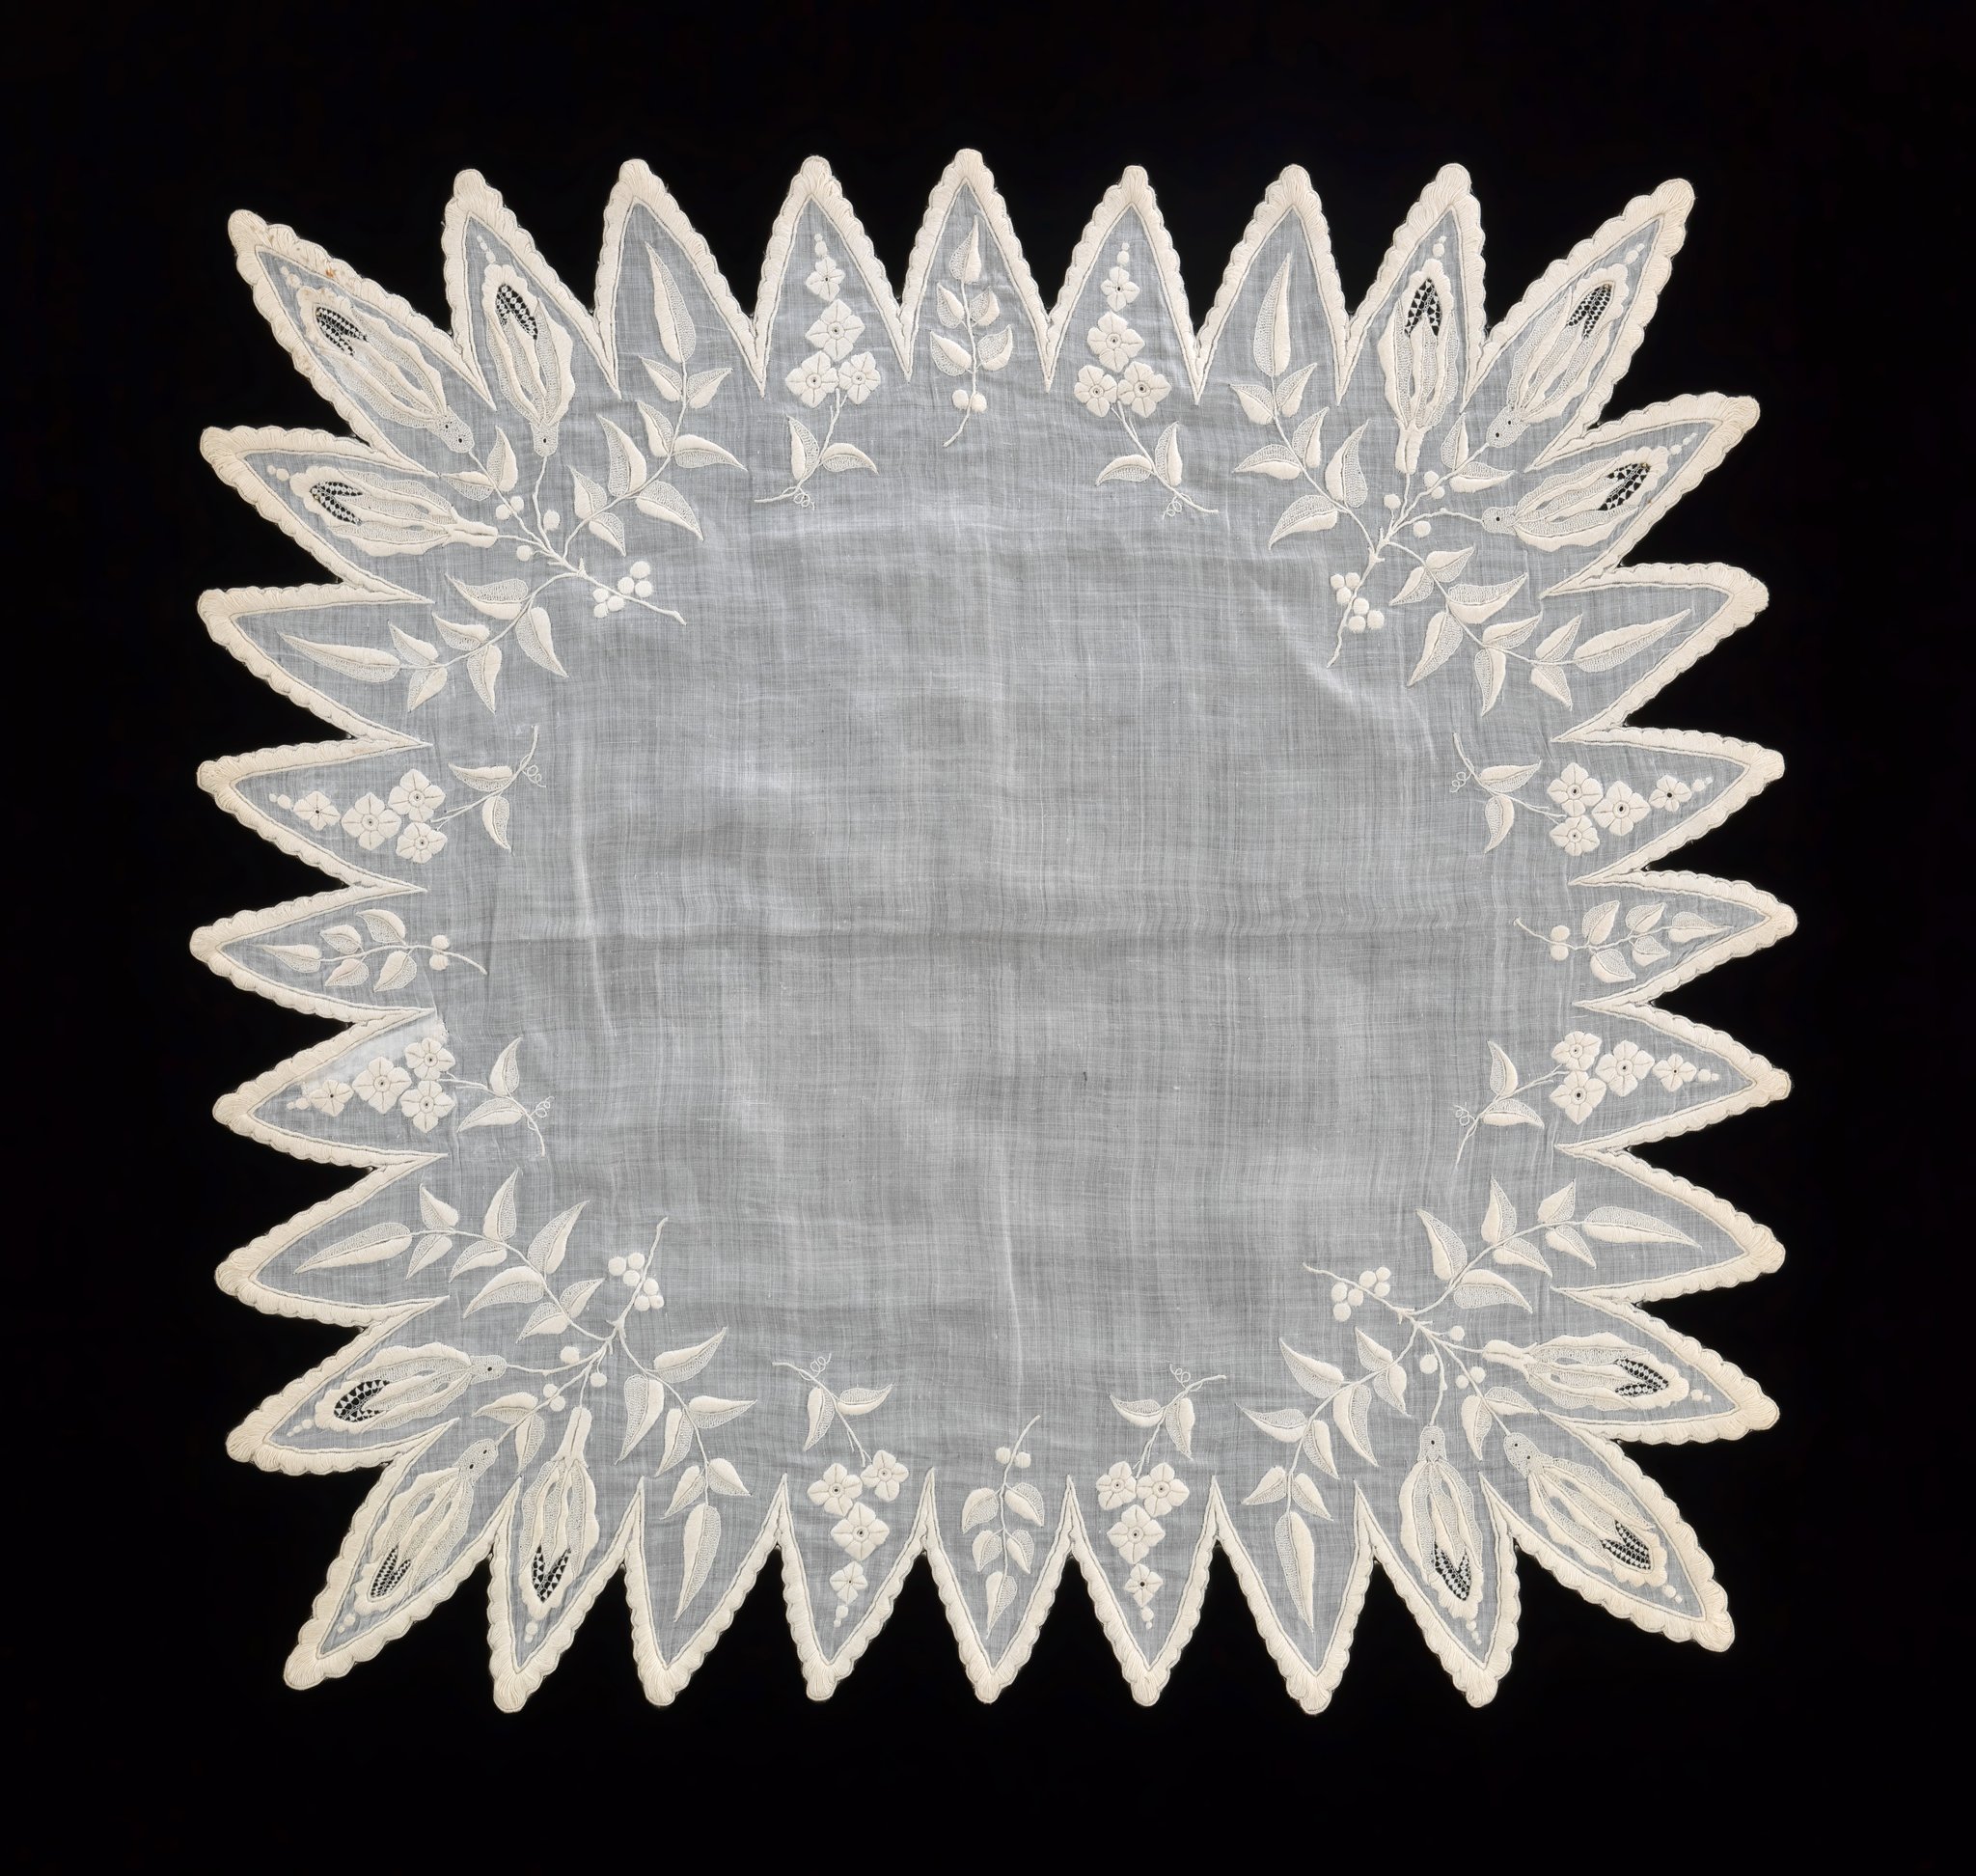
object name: handkerchief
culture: american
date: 1826-1850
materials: cotton